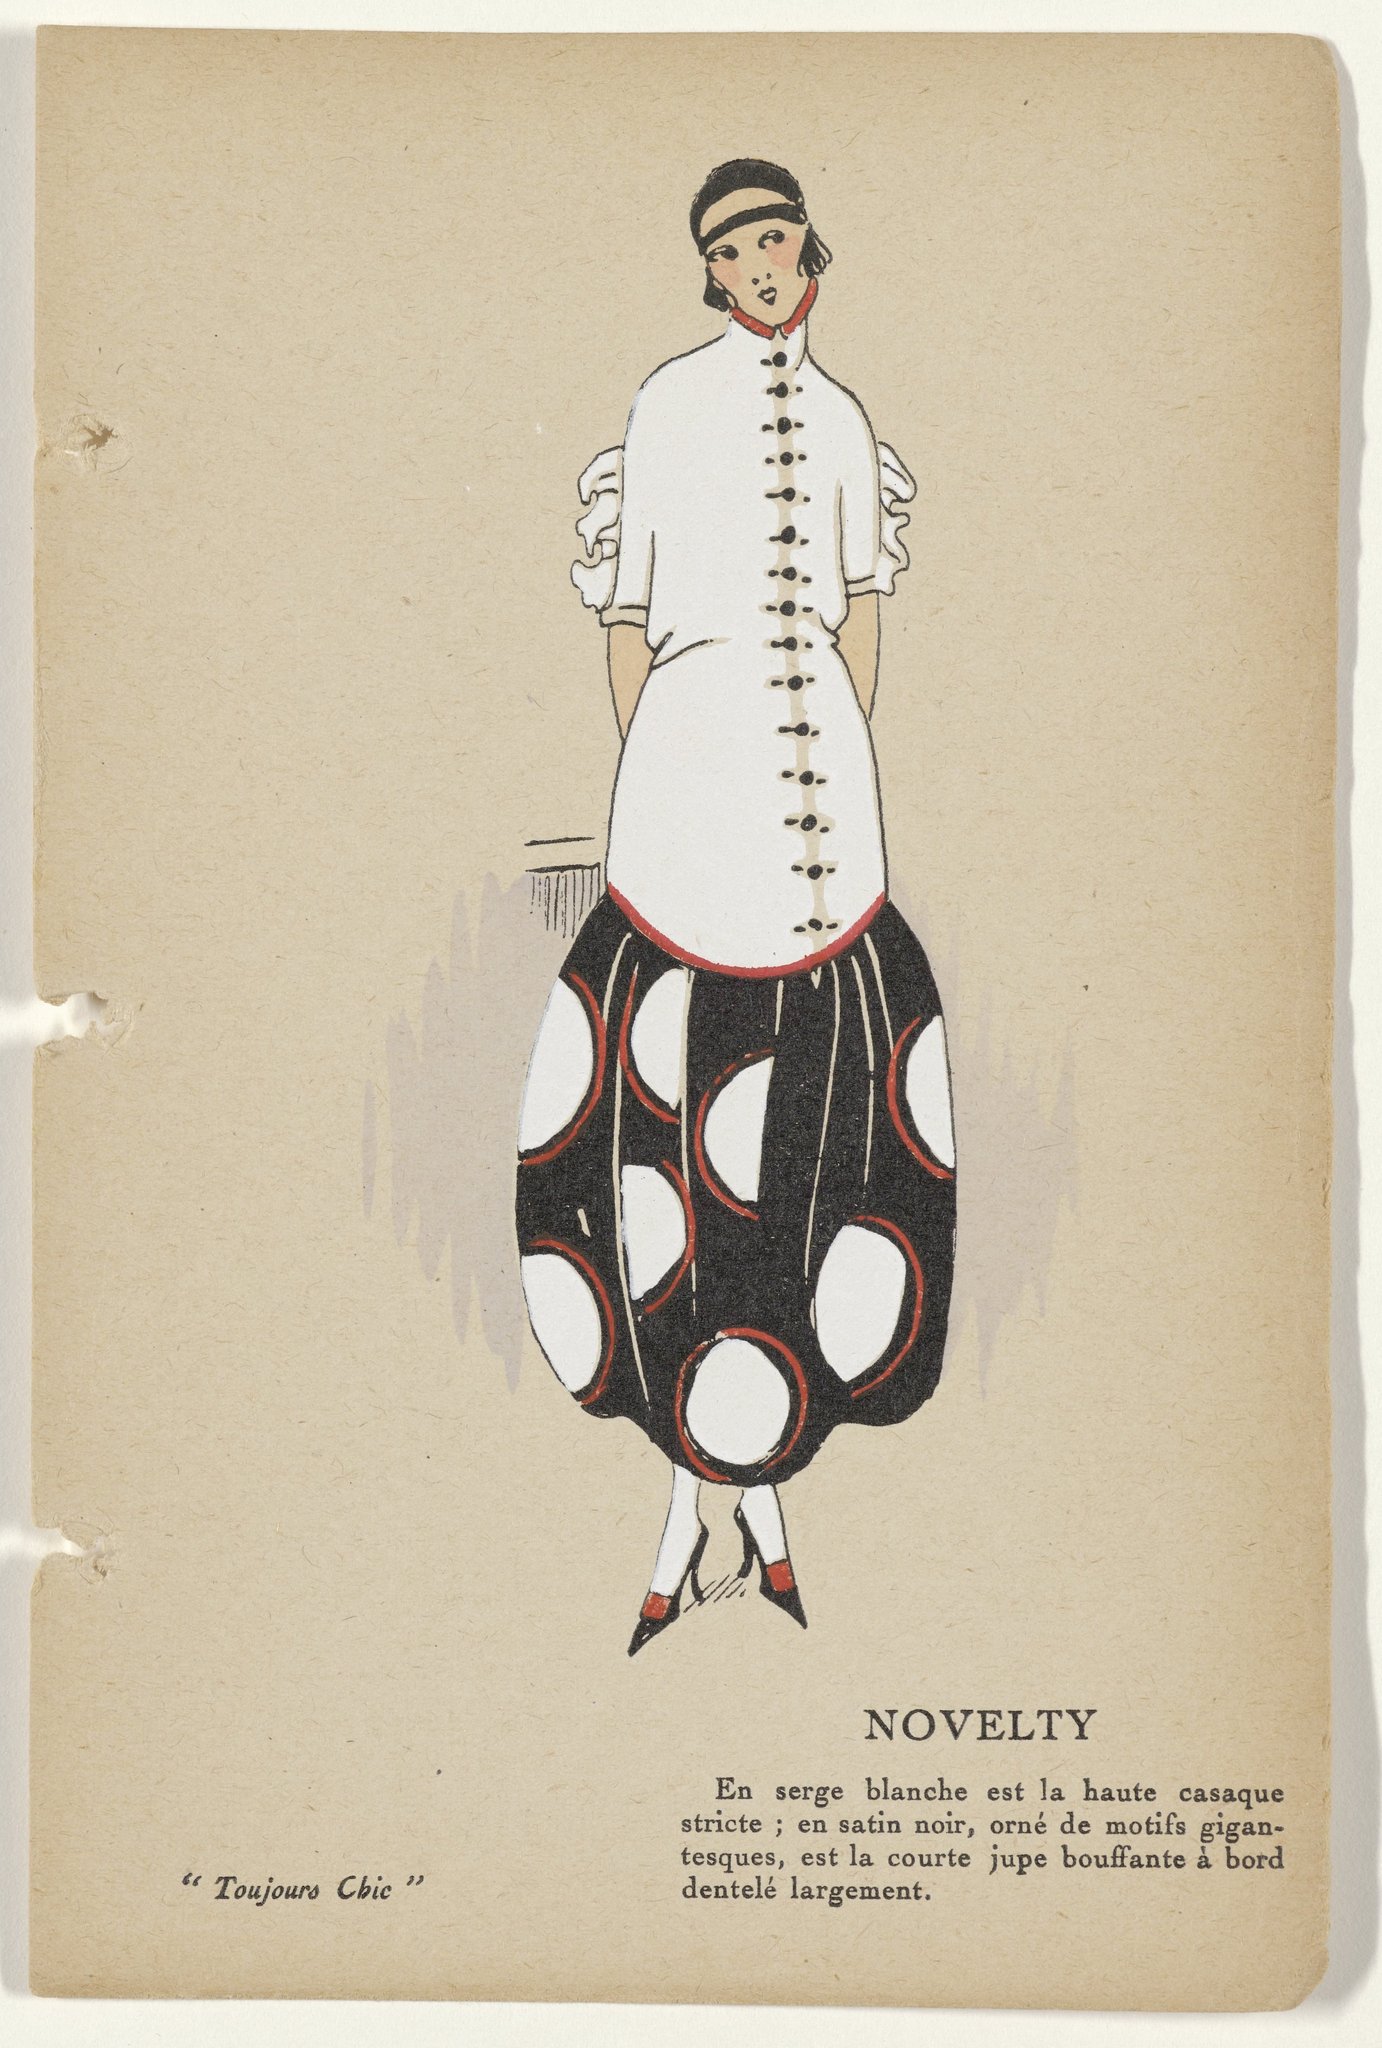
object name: fashion print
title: Toujours Chic Les Robes, Hiver 1921-1922: Novelty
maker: g-p. joumard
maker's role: publisher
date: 1921-1922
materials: paper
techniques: letterpress printing, pochoir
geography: paris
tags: fashion plates, skirt (+ women's clothes), dress, gown (+ women's clothes)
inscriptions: date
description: Japon bestaande uit een casaque van witte serge en een rok van zwart satijn met cirkels. Prent uit Catalogus "Toujours Chic" waarin een overzicht van de wintermode 1921-1922 in 80 prentjes in pochoir techniek.